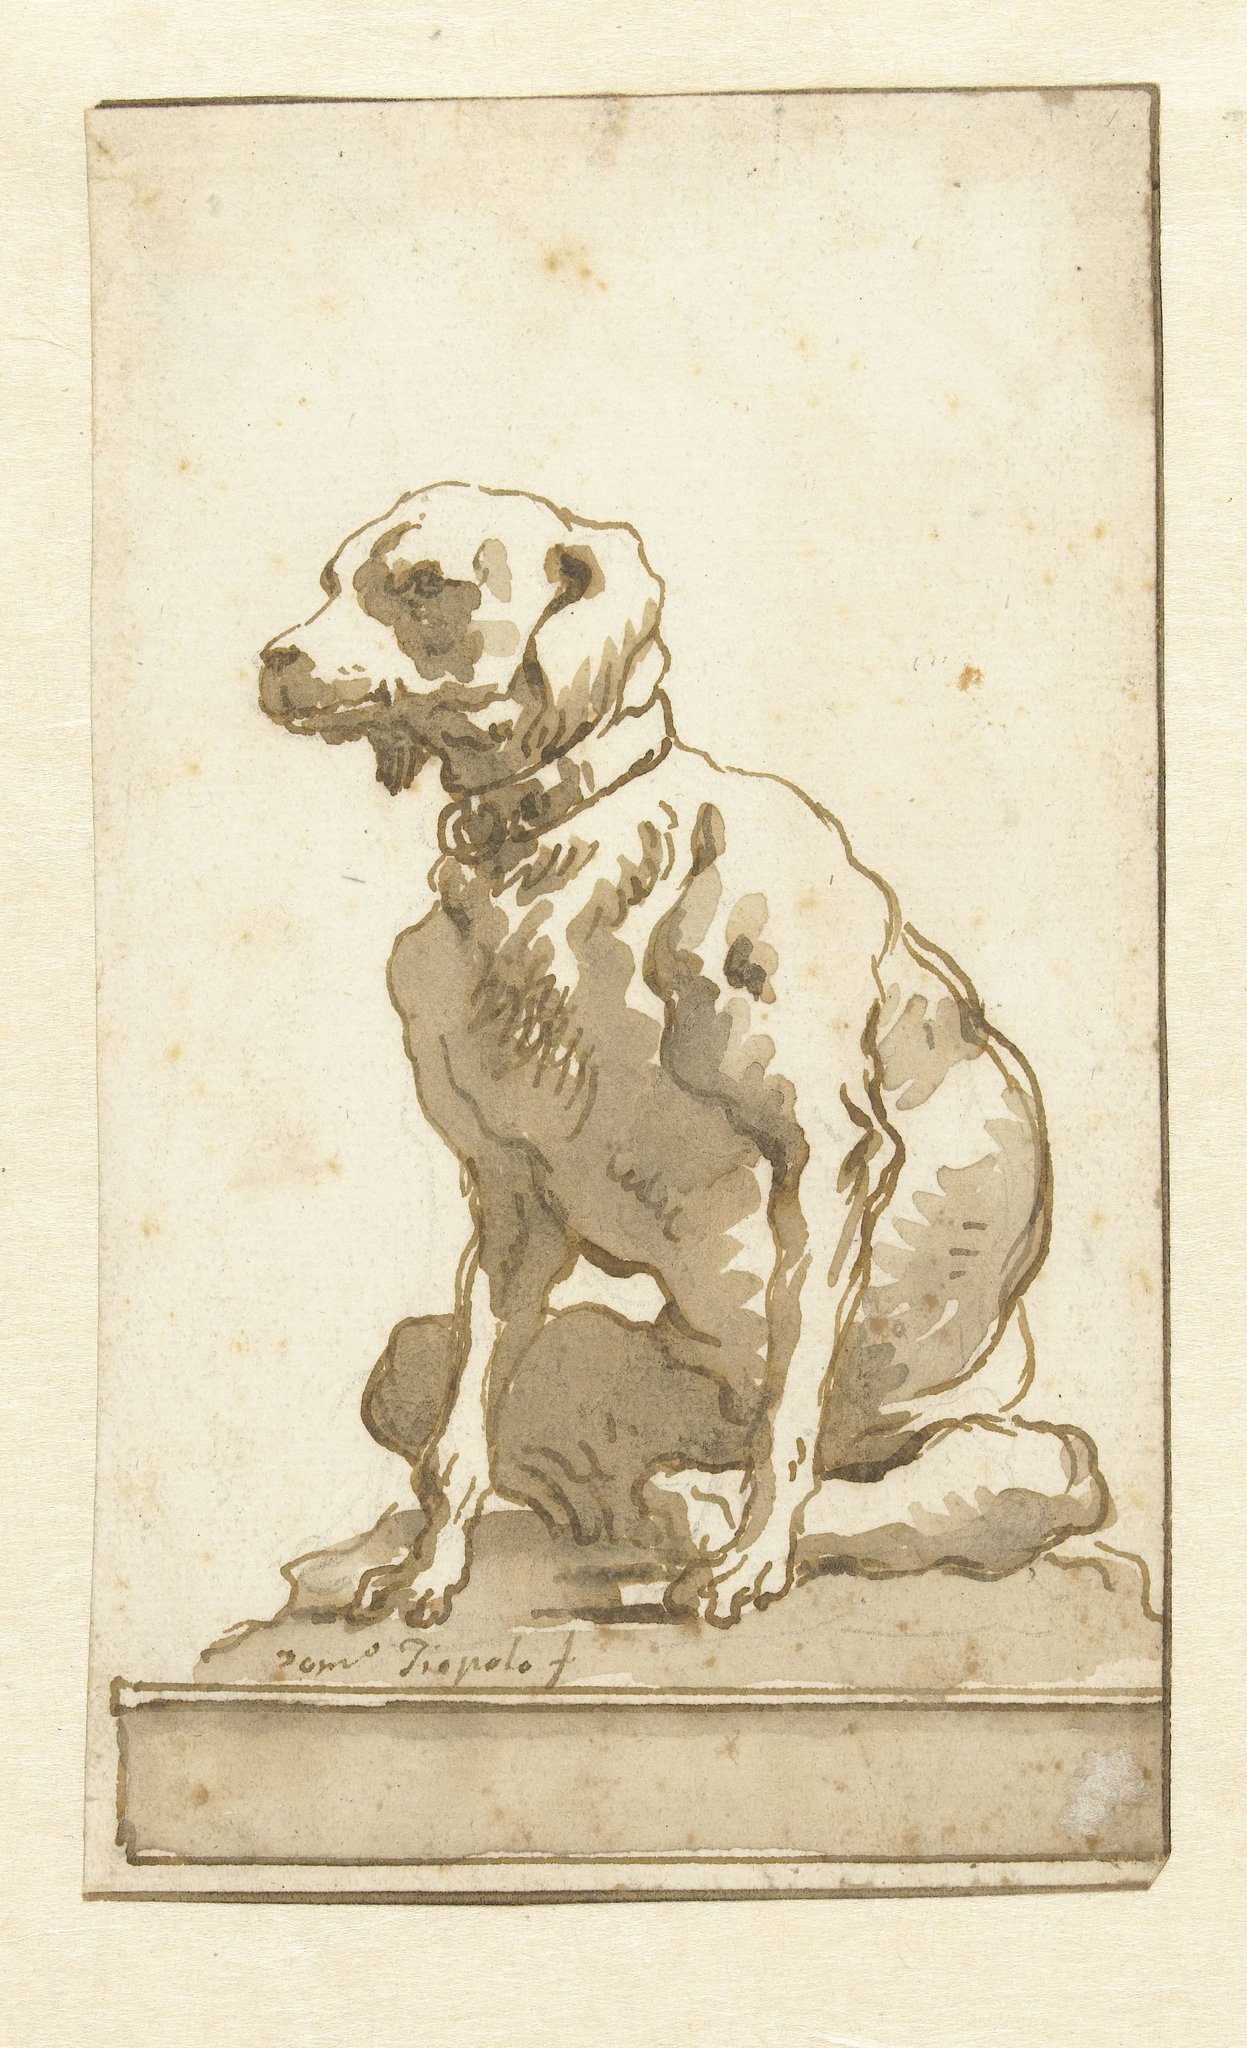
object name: drawing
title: Sitting Dog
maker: giovanni domenico tiepolo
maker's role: draughtsman, print maker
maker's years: 1727-1804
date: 1775-1795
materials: ink, paper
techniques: brush, pen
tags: dog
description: This drawing was probably used for a decoration in the villa of the Tiepolo family itself. The dog was copied from a study previously used by Domenico's father Giambattista Tiepolo for a fresco in Würzburg. The artist signed this relatively small, but elaborate drawing in full. This indicates that Domenico also intended to sell his design as an independent work of art.